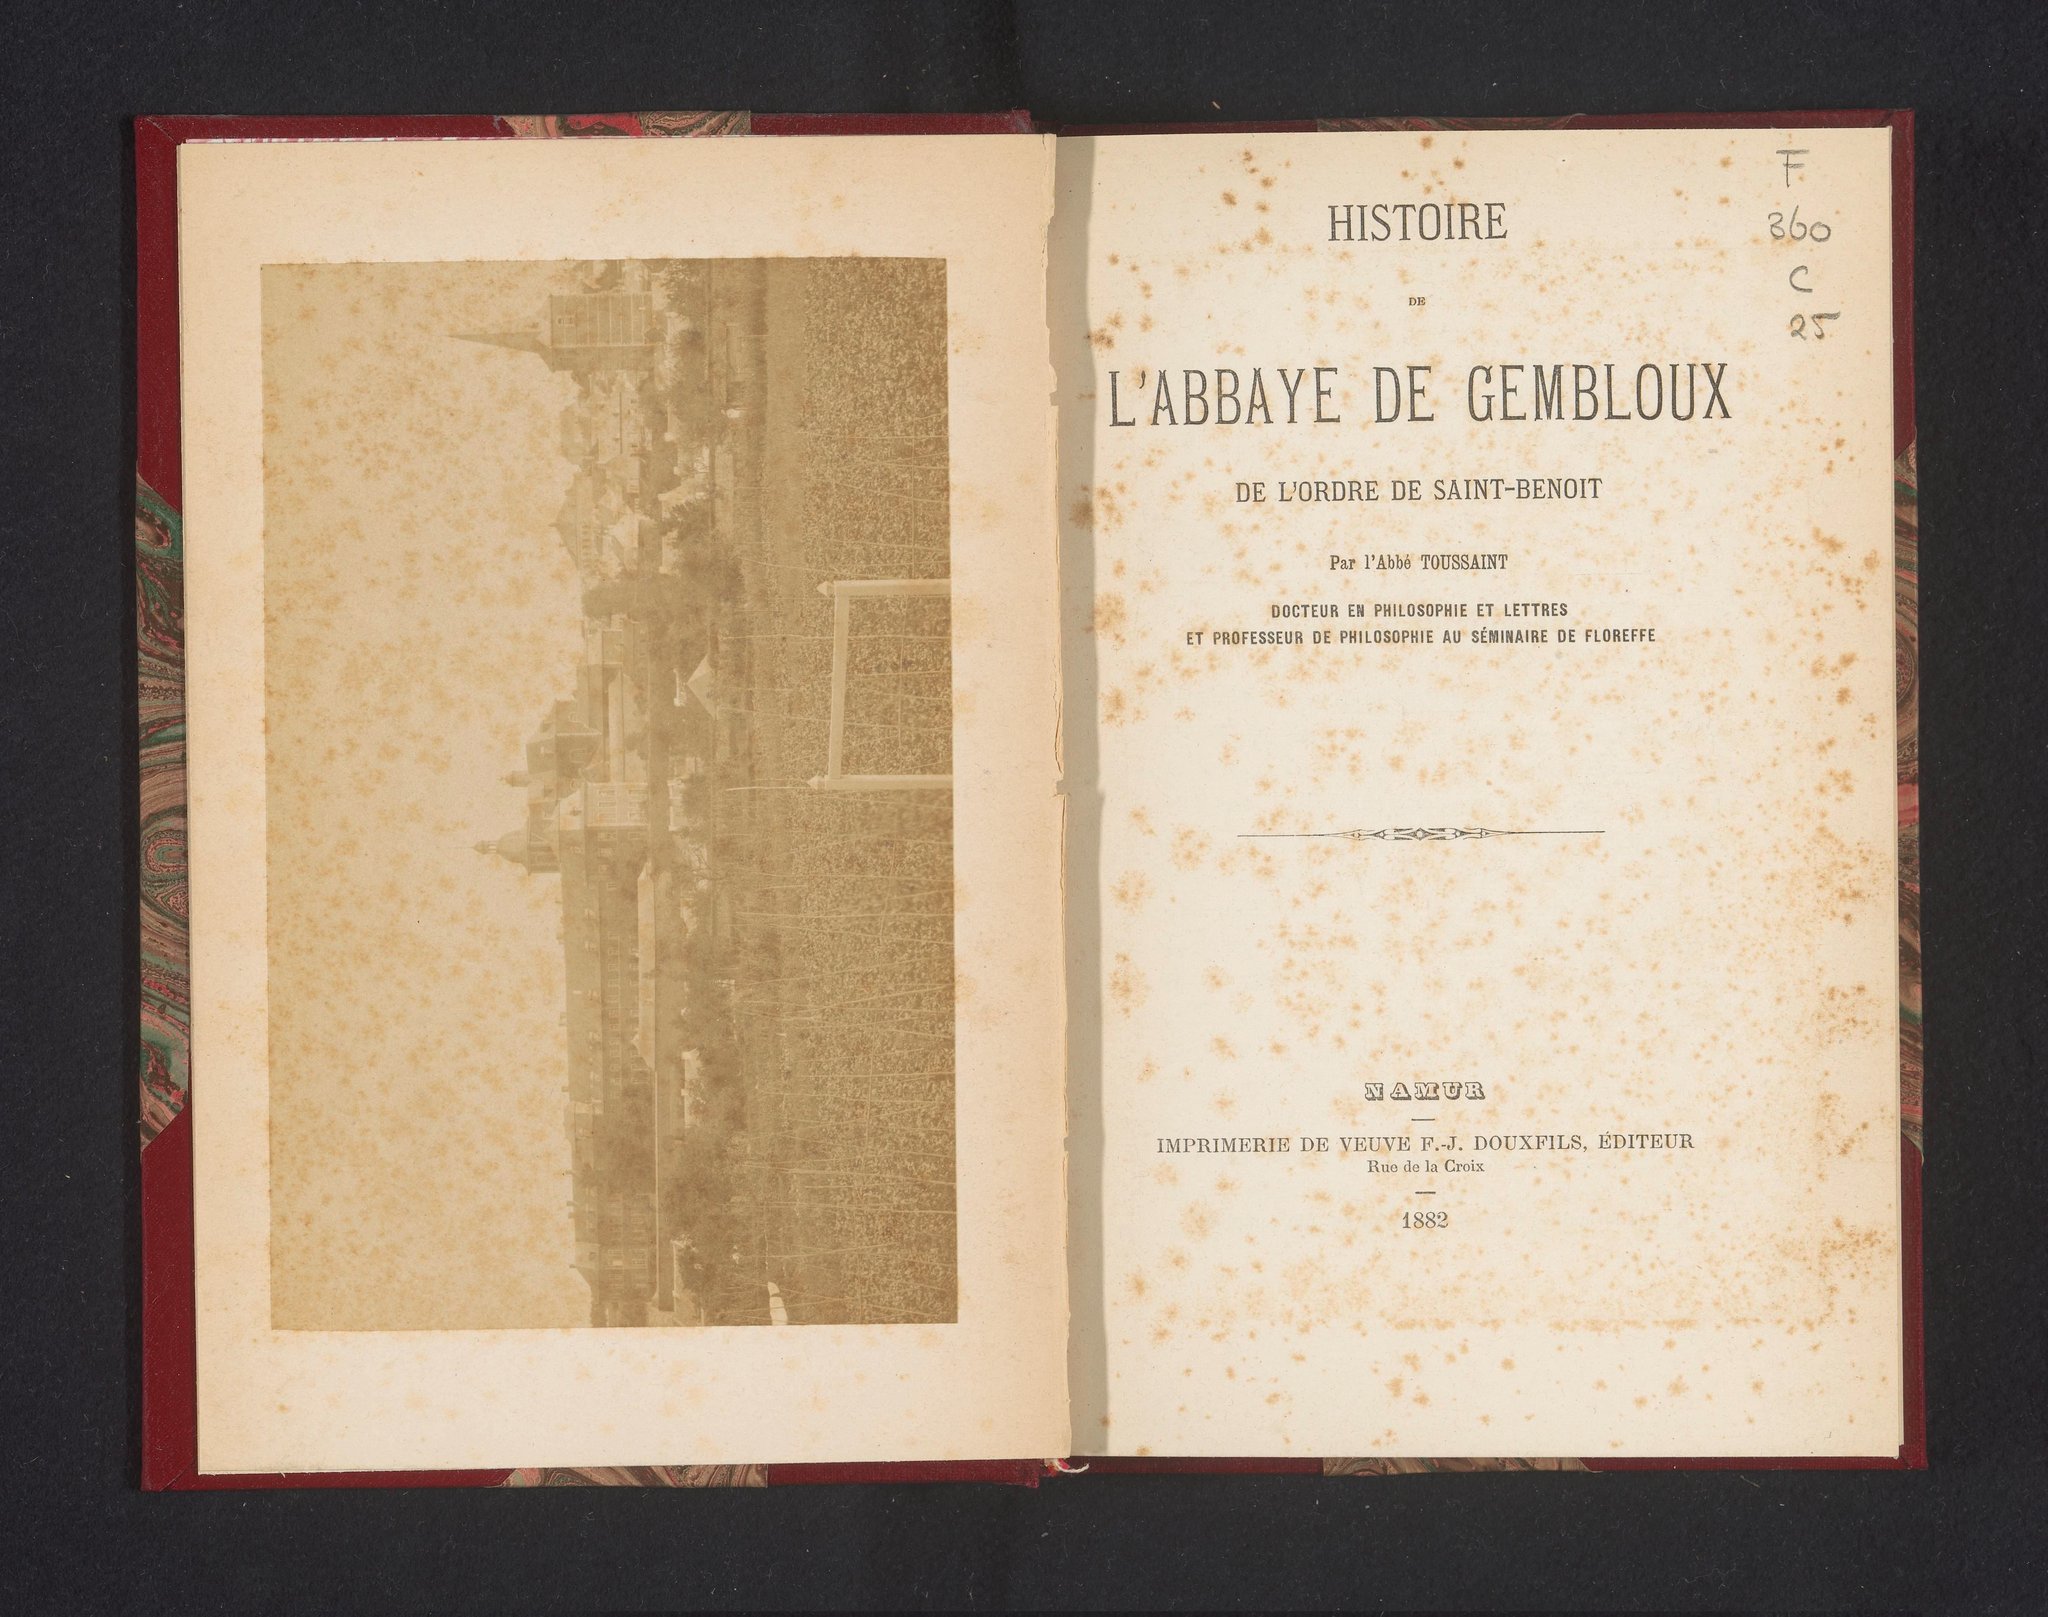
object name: book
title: Histoire de l'abbaye de Gembloux, de l'ordre de Saint-Benoît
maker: m. labbé toussaint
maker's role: abt, professor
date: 1882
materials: linen, paper, photographic support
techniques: albumen print, decorated paper, printing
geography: namur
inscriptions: annotation: ‘Hommage [...] l'auteur/ 1200-’, date: ‘May 1988’